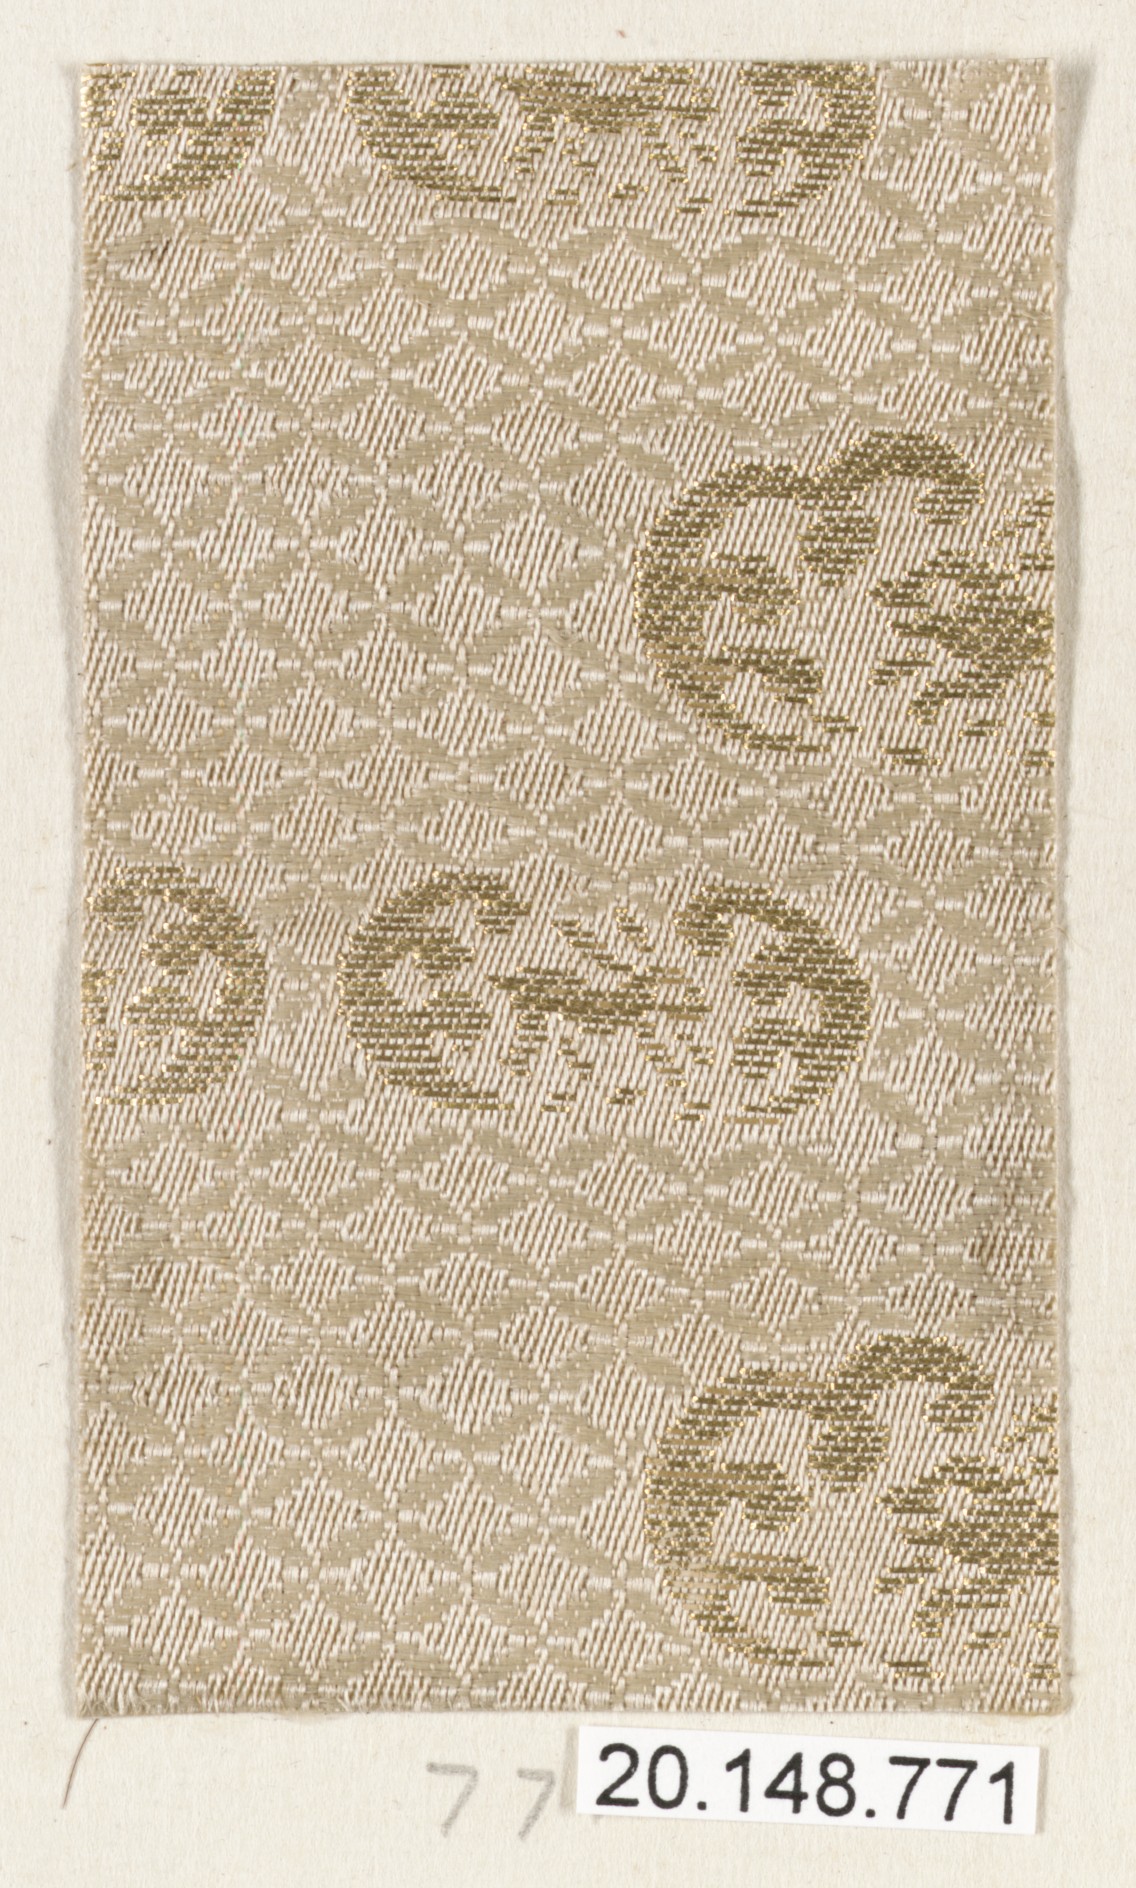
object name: piece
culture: japanese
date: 1601-1700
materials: silk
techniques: compound weave